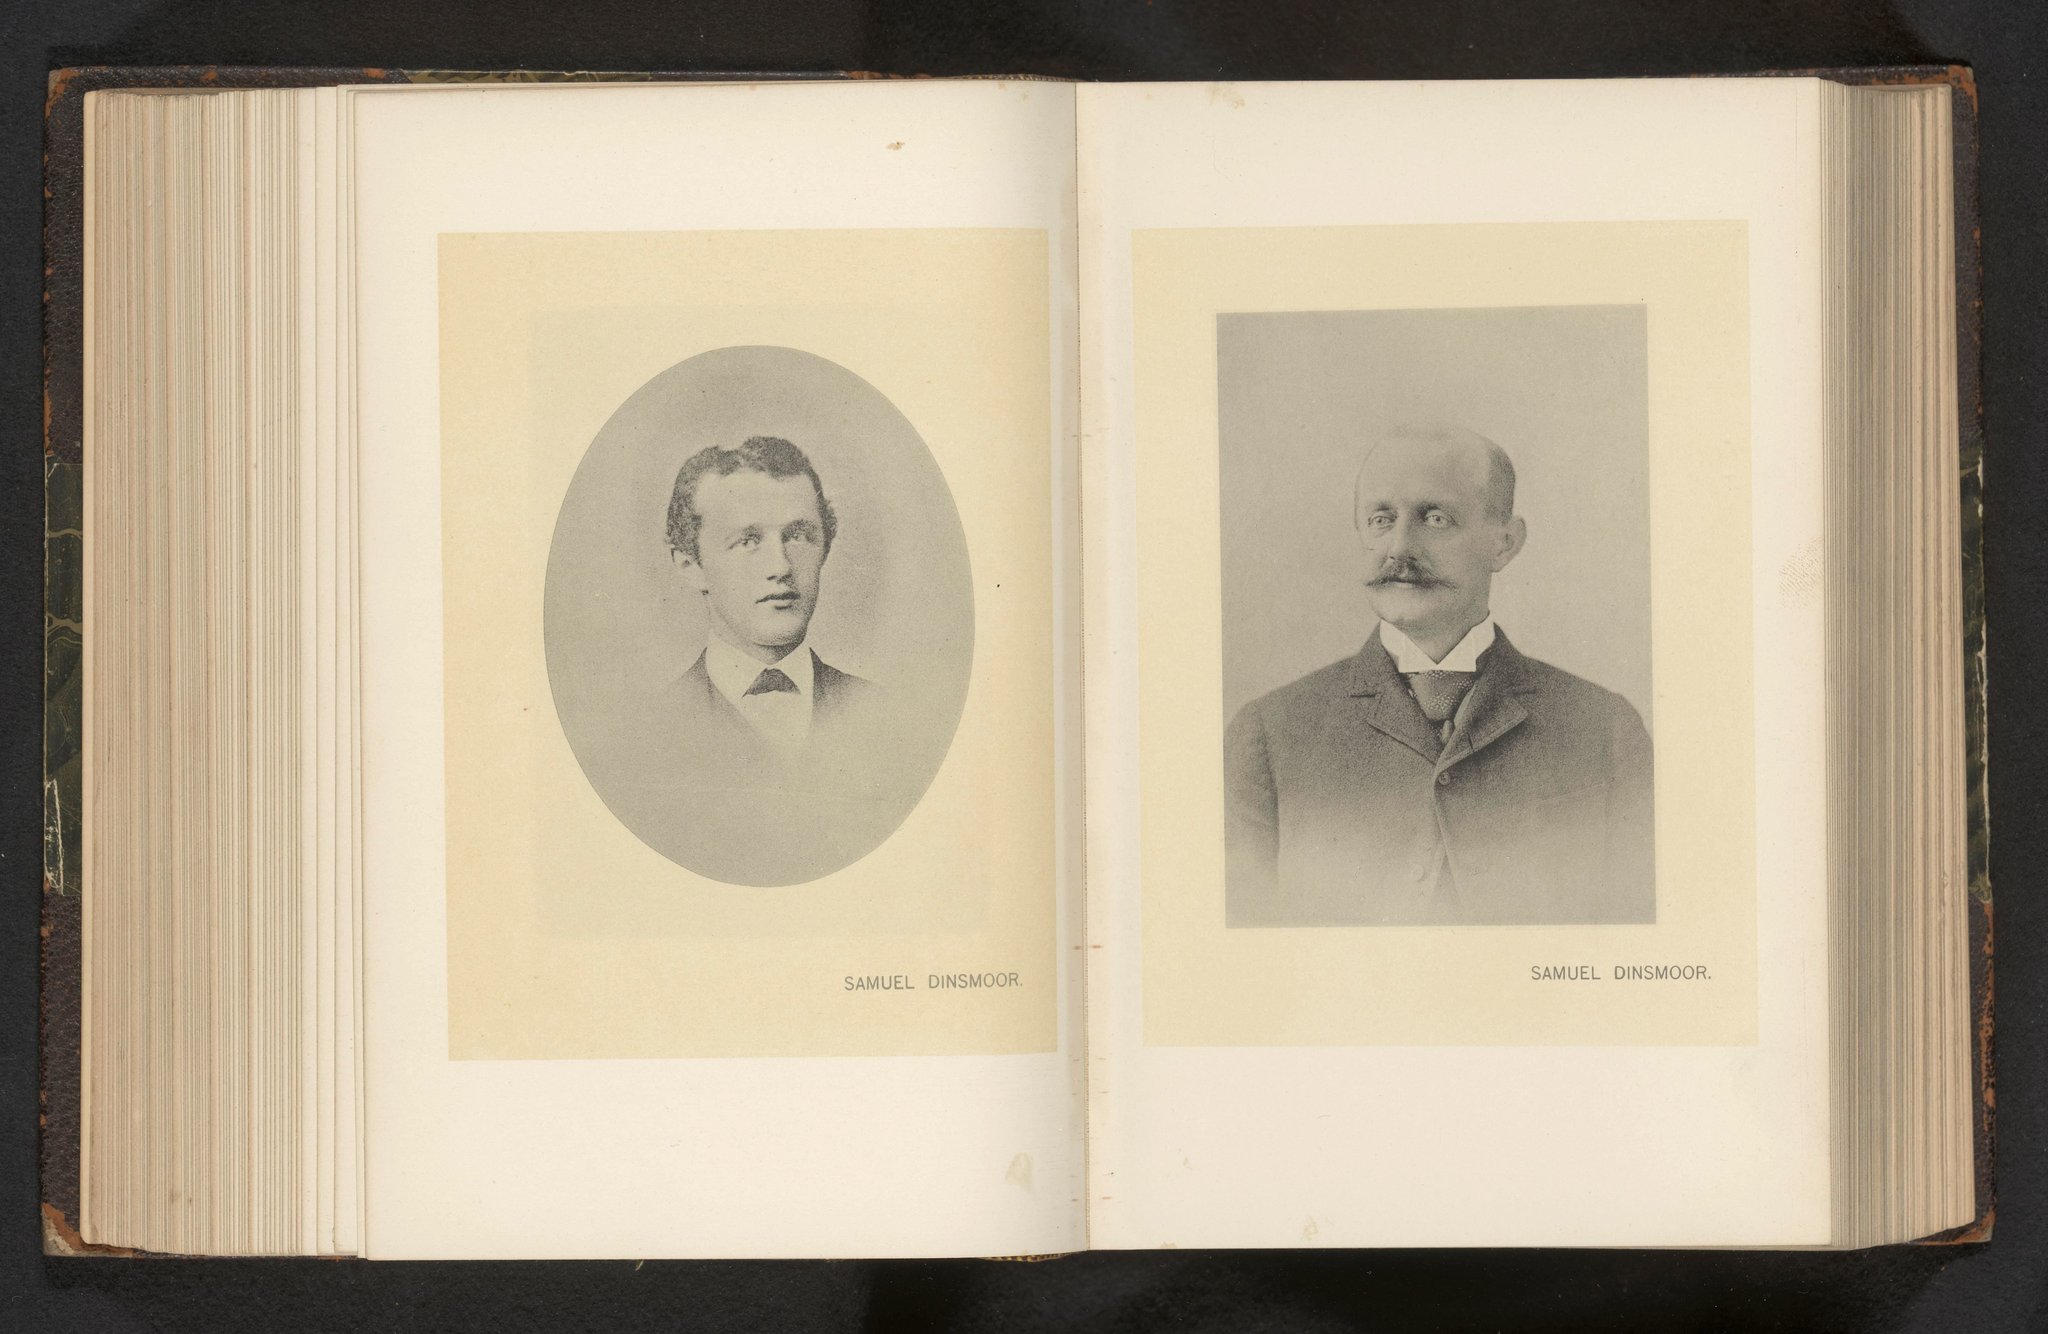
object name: page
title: Samuel Dinsmoor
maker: Anonymous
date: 1889-1894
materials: paper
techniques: photoaquatint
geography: boston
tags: adult man